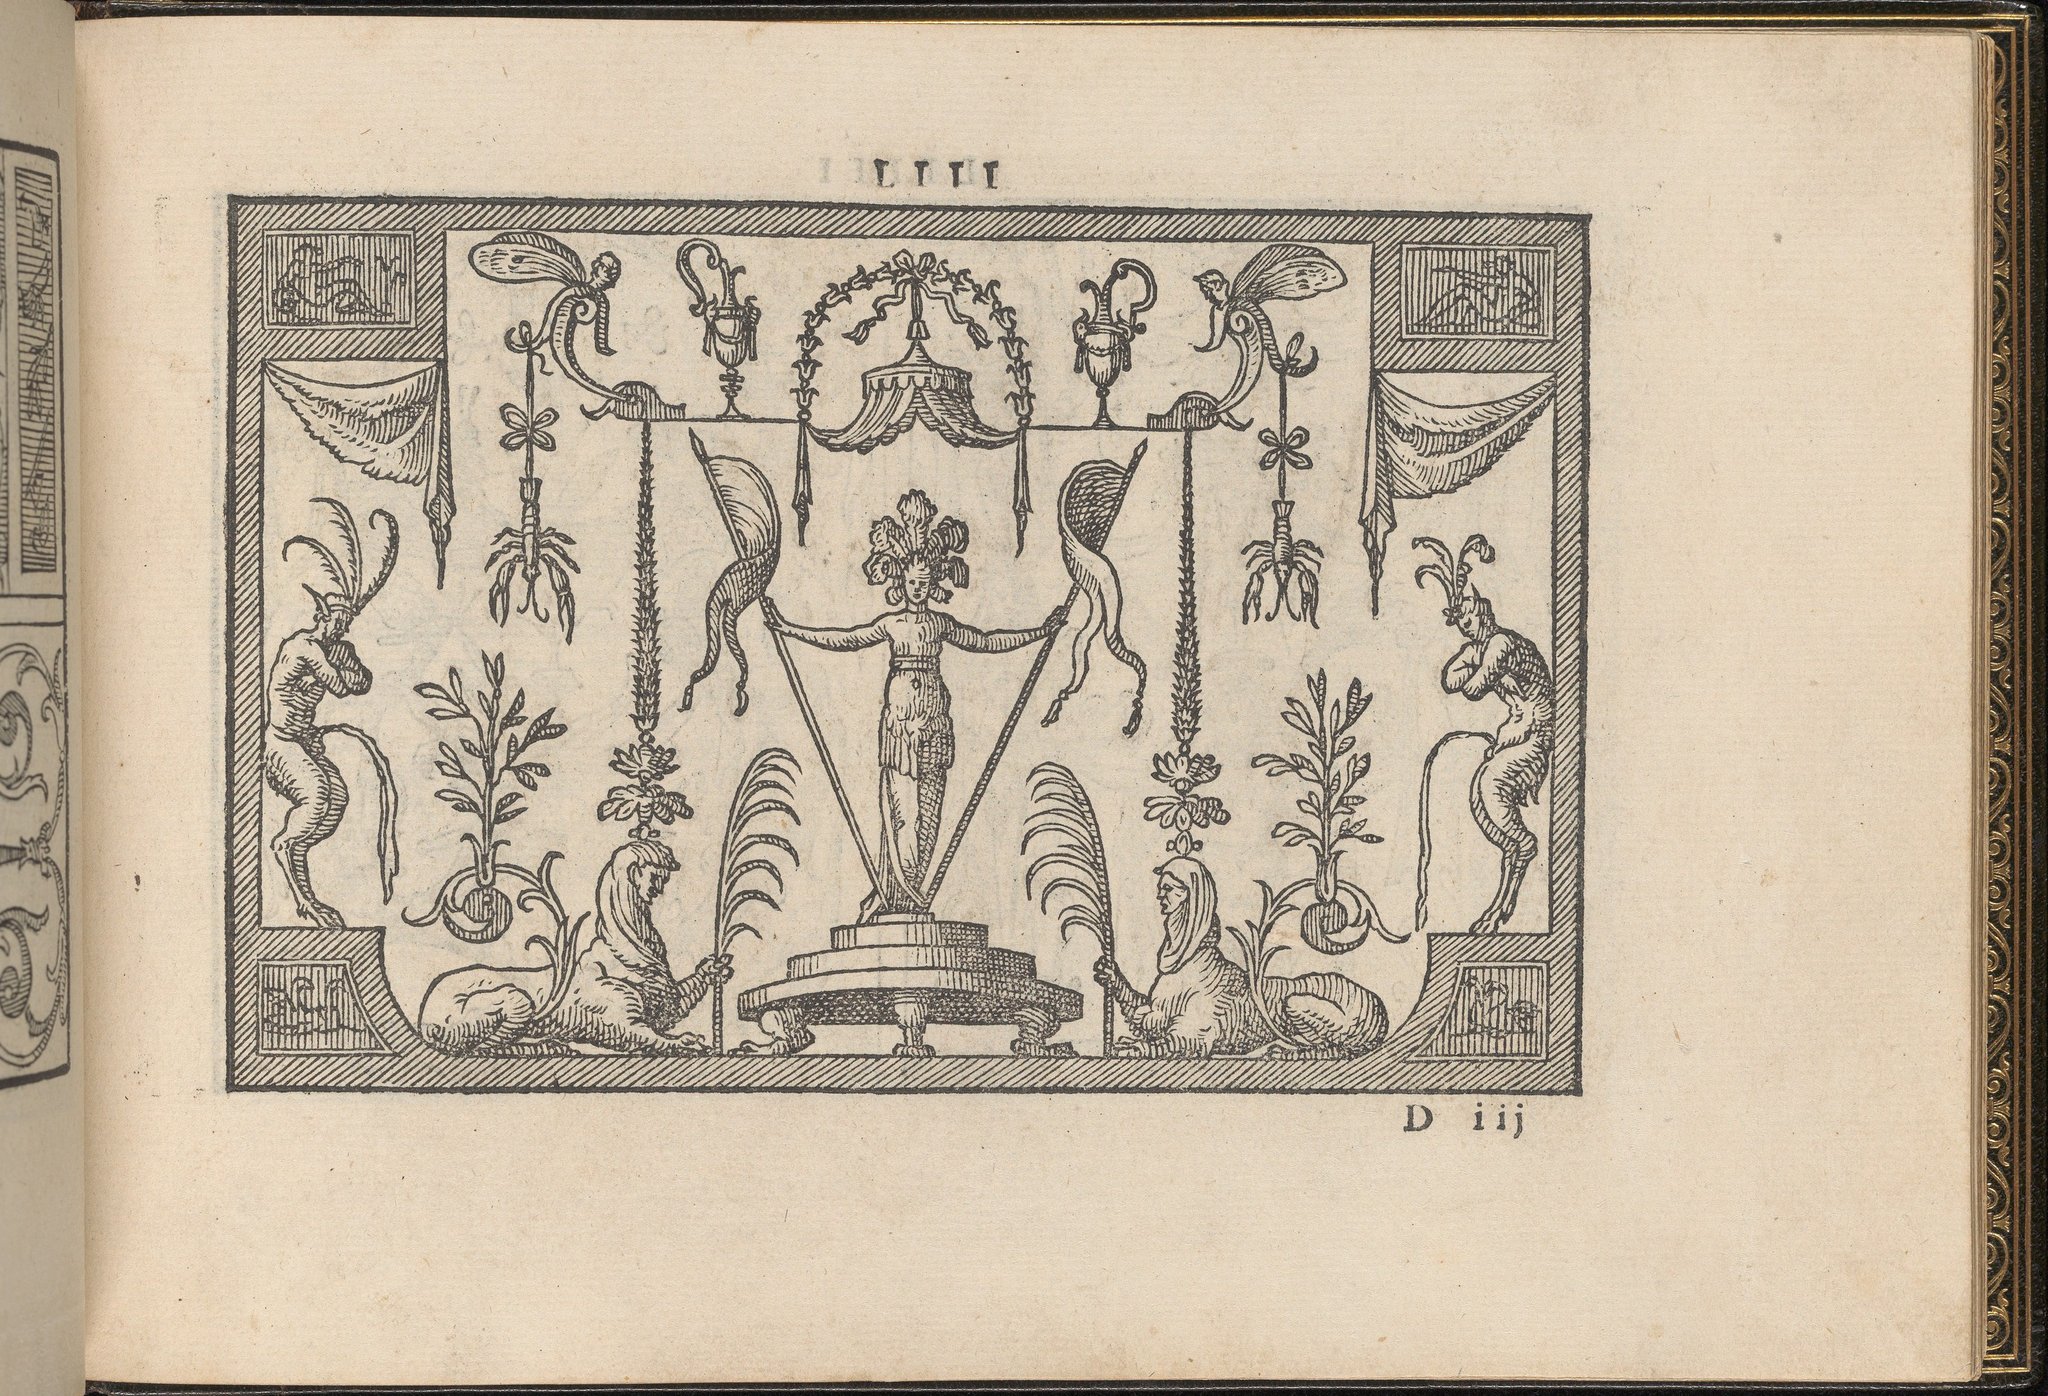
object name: book print ornament architecture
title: La Vera Perfettione del Disegno di varie sorti di recami, page 27 (recto)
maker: giovanni ostaus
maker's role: publisher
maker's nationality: italian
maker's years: 1507-1607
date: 1567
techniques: woodcut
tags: sphinx